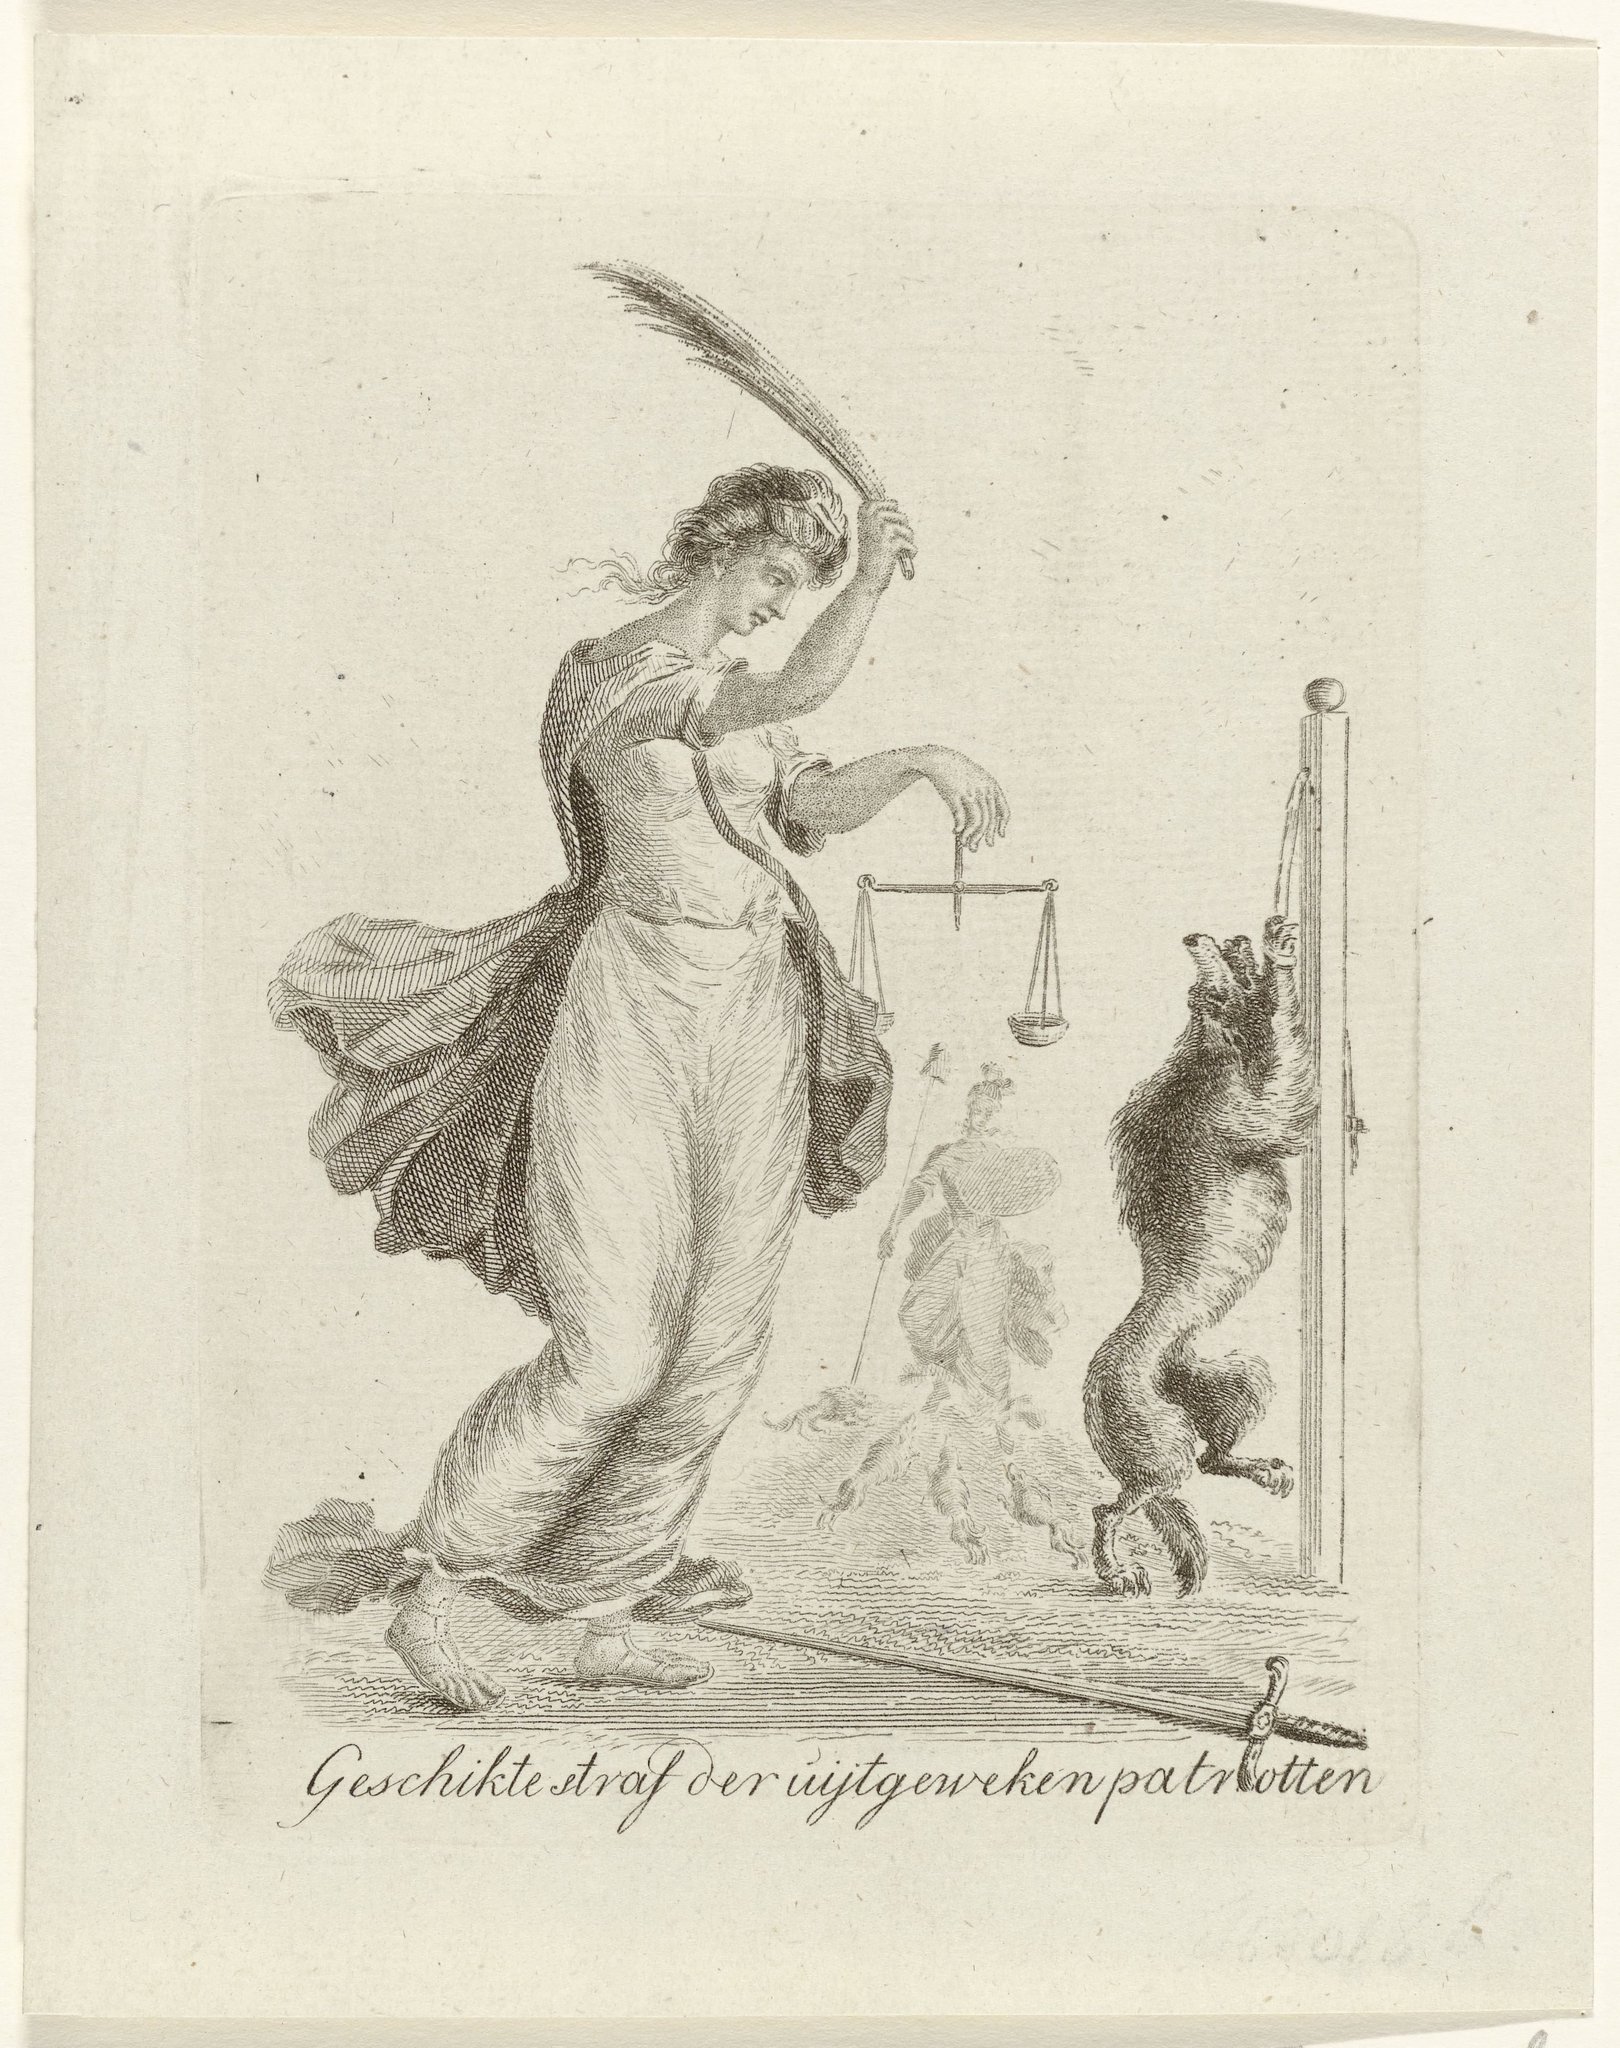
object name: cartoon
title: Geschikte straf der uijtgeweken patriotten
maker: Anonymous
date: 1787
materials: paper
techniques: engraving, etching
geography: northern netherlands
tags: justice, 'justitia'; 'giustitia divina' (ripa) ~ one of the four cardinal virtues, dog (+ animal(s) being wounded), flogging, scourging (in public), patriots (1780-1795)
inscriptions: collector's mark: Lugt 2228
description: Spotprent op patriotten, na het herstel van de prins van Oranje in 1787. De Gerechtigheid geselt een keeshond die met zijn voorpoten aan een paal is vastgebonden. Op de achtergrond vallen keeshonden de Vrijheid aan.